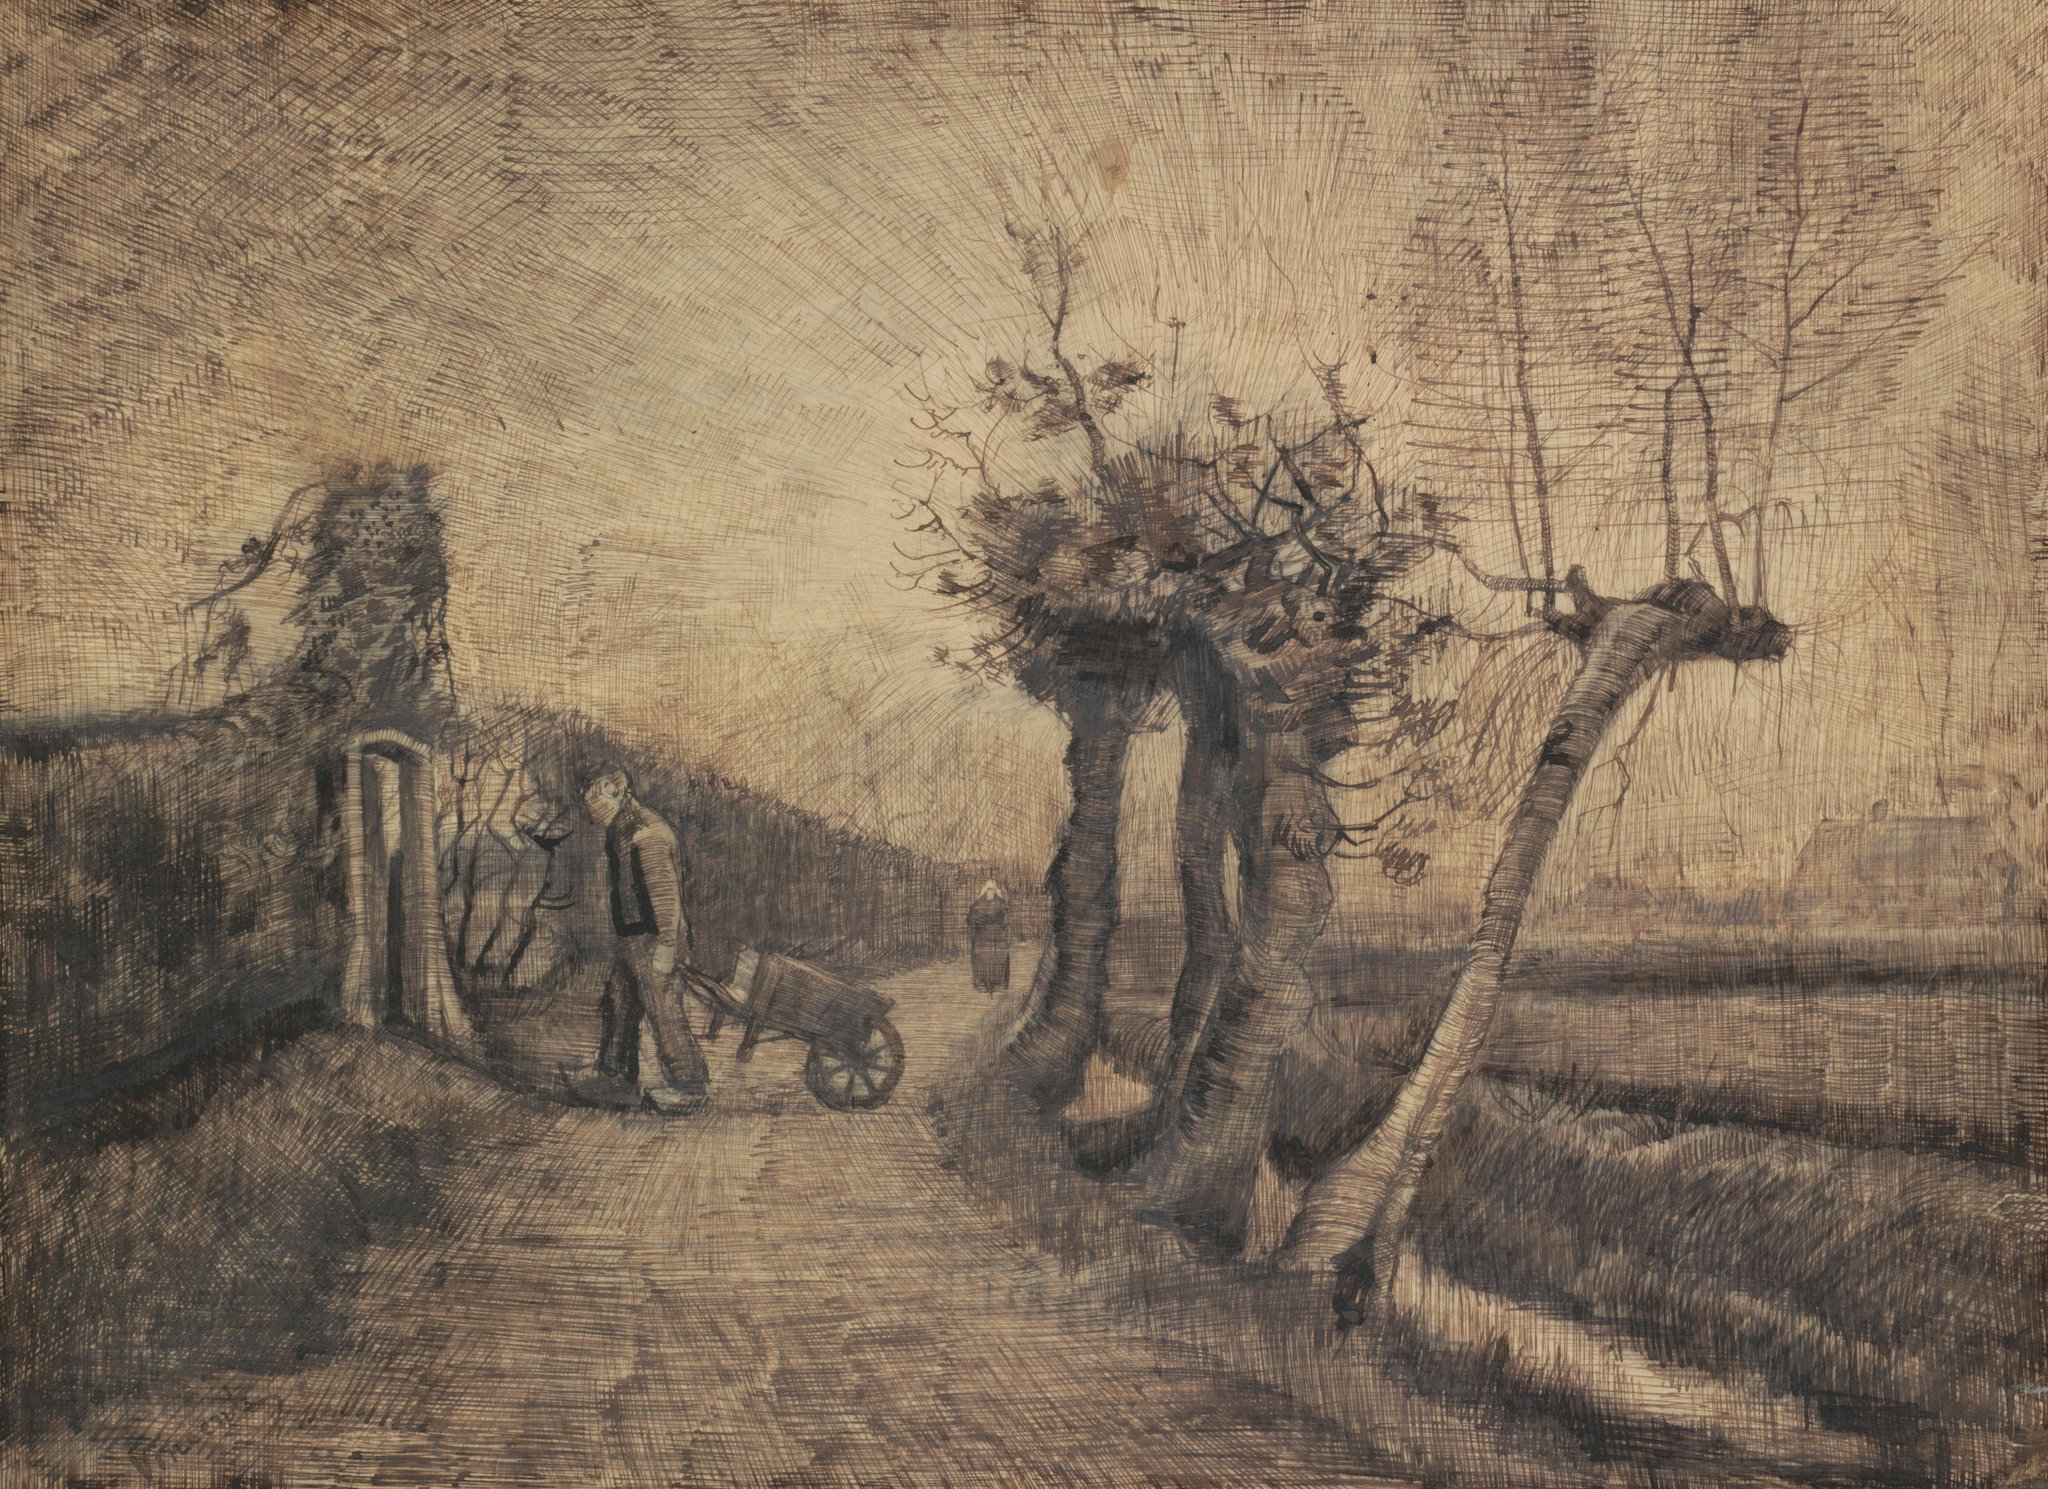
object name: drawing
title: Road behind the Parsonage Garden in Nuenen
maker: vincent van gogh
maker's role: draughtsman, painter, print maker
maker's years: 1853-1890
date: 1803-1884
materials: paper, pencil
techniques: brush, pen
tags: trees: pollard willow, carrying something with barrow, male sex; man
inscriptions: signature: ‘Vincent’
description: Weg met knotwilgen en een man met een kruiwagen.